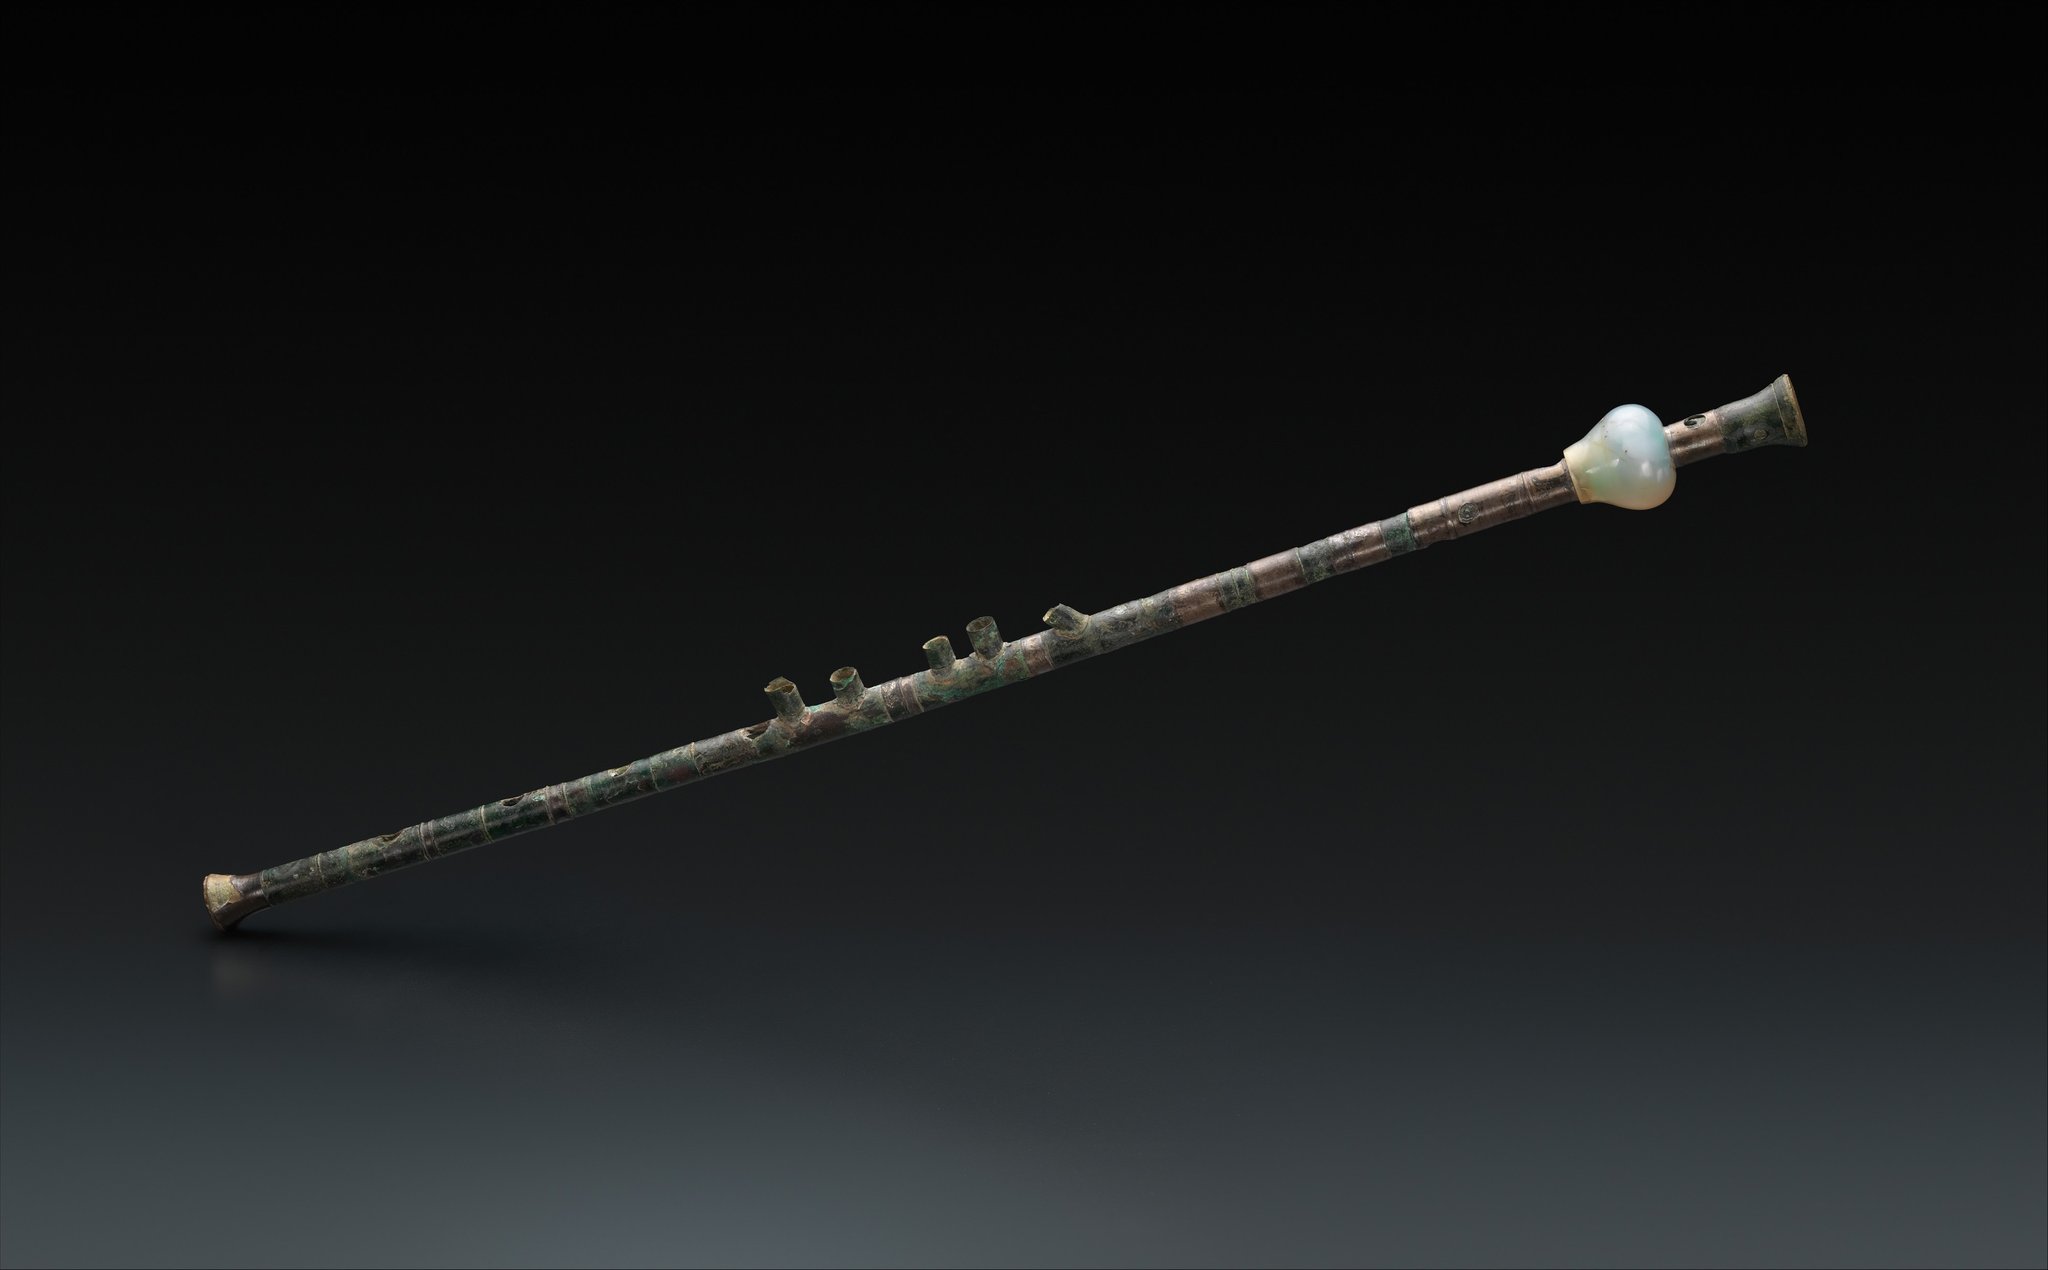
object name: tibia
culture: syrian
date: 1-500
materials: stone, ivory, silver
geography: syria